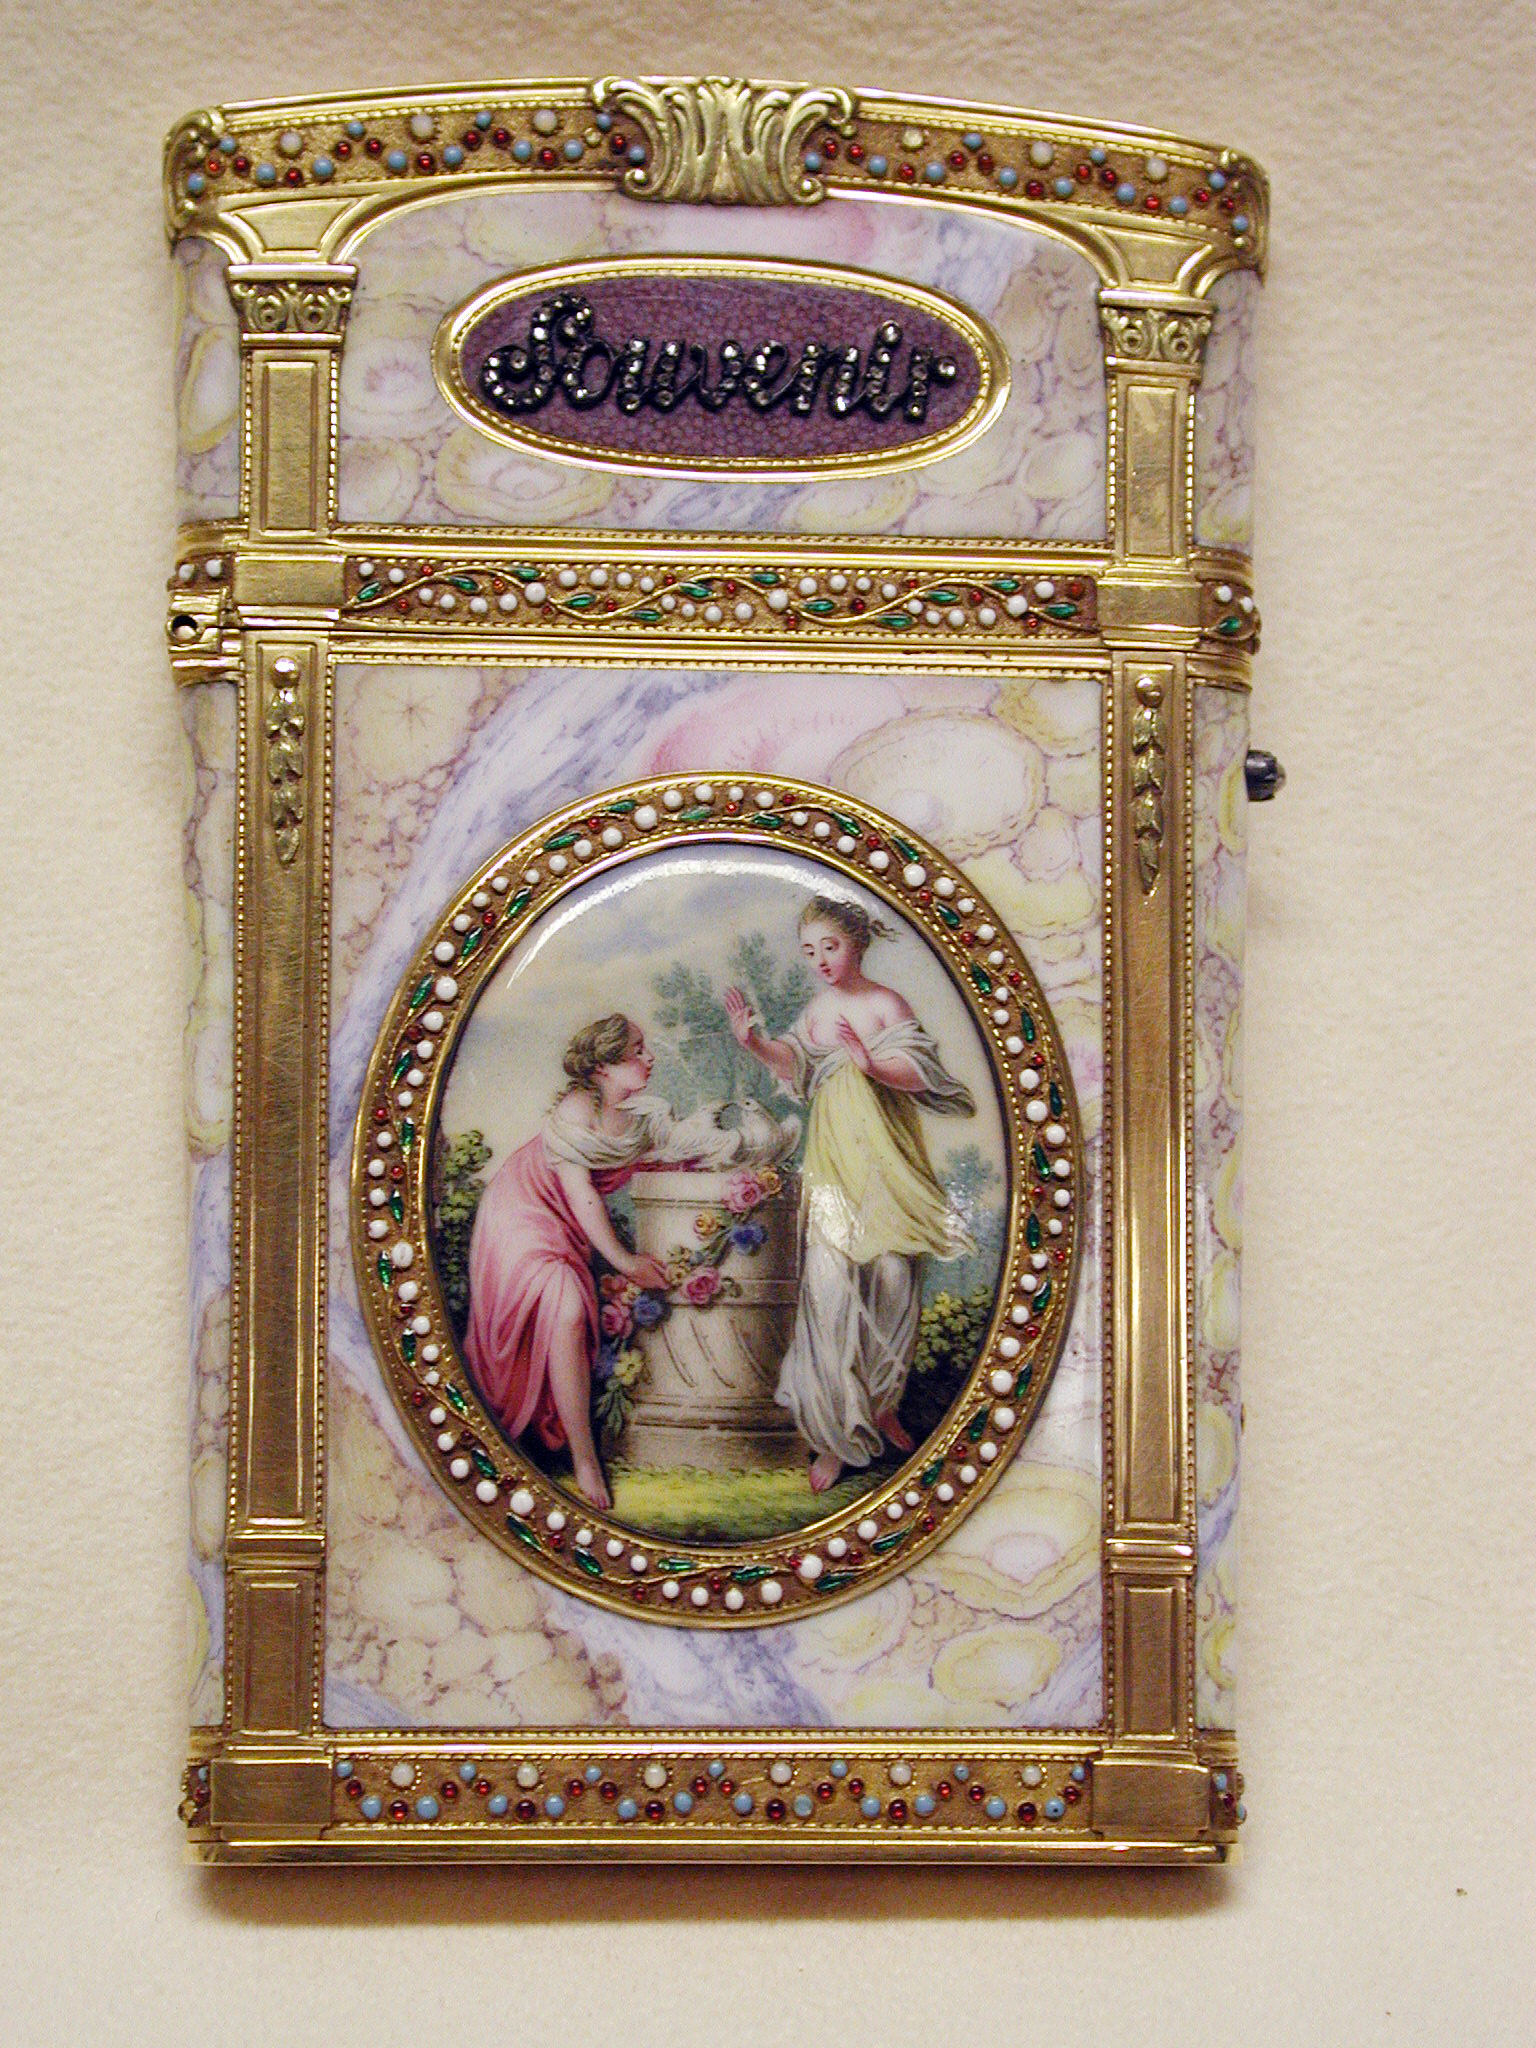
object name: souvenir, painting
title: Souvenir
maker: barthélemy pillieux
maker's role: maker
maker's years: 1764-1774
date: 1780-1781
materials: diamond, enamel, gold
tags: birds,women